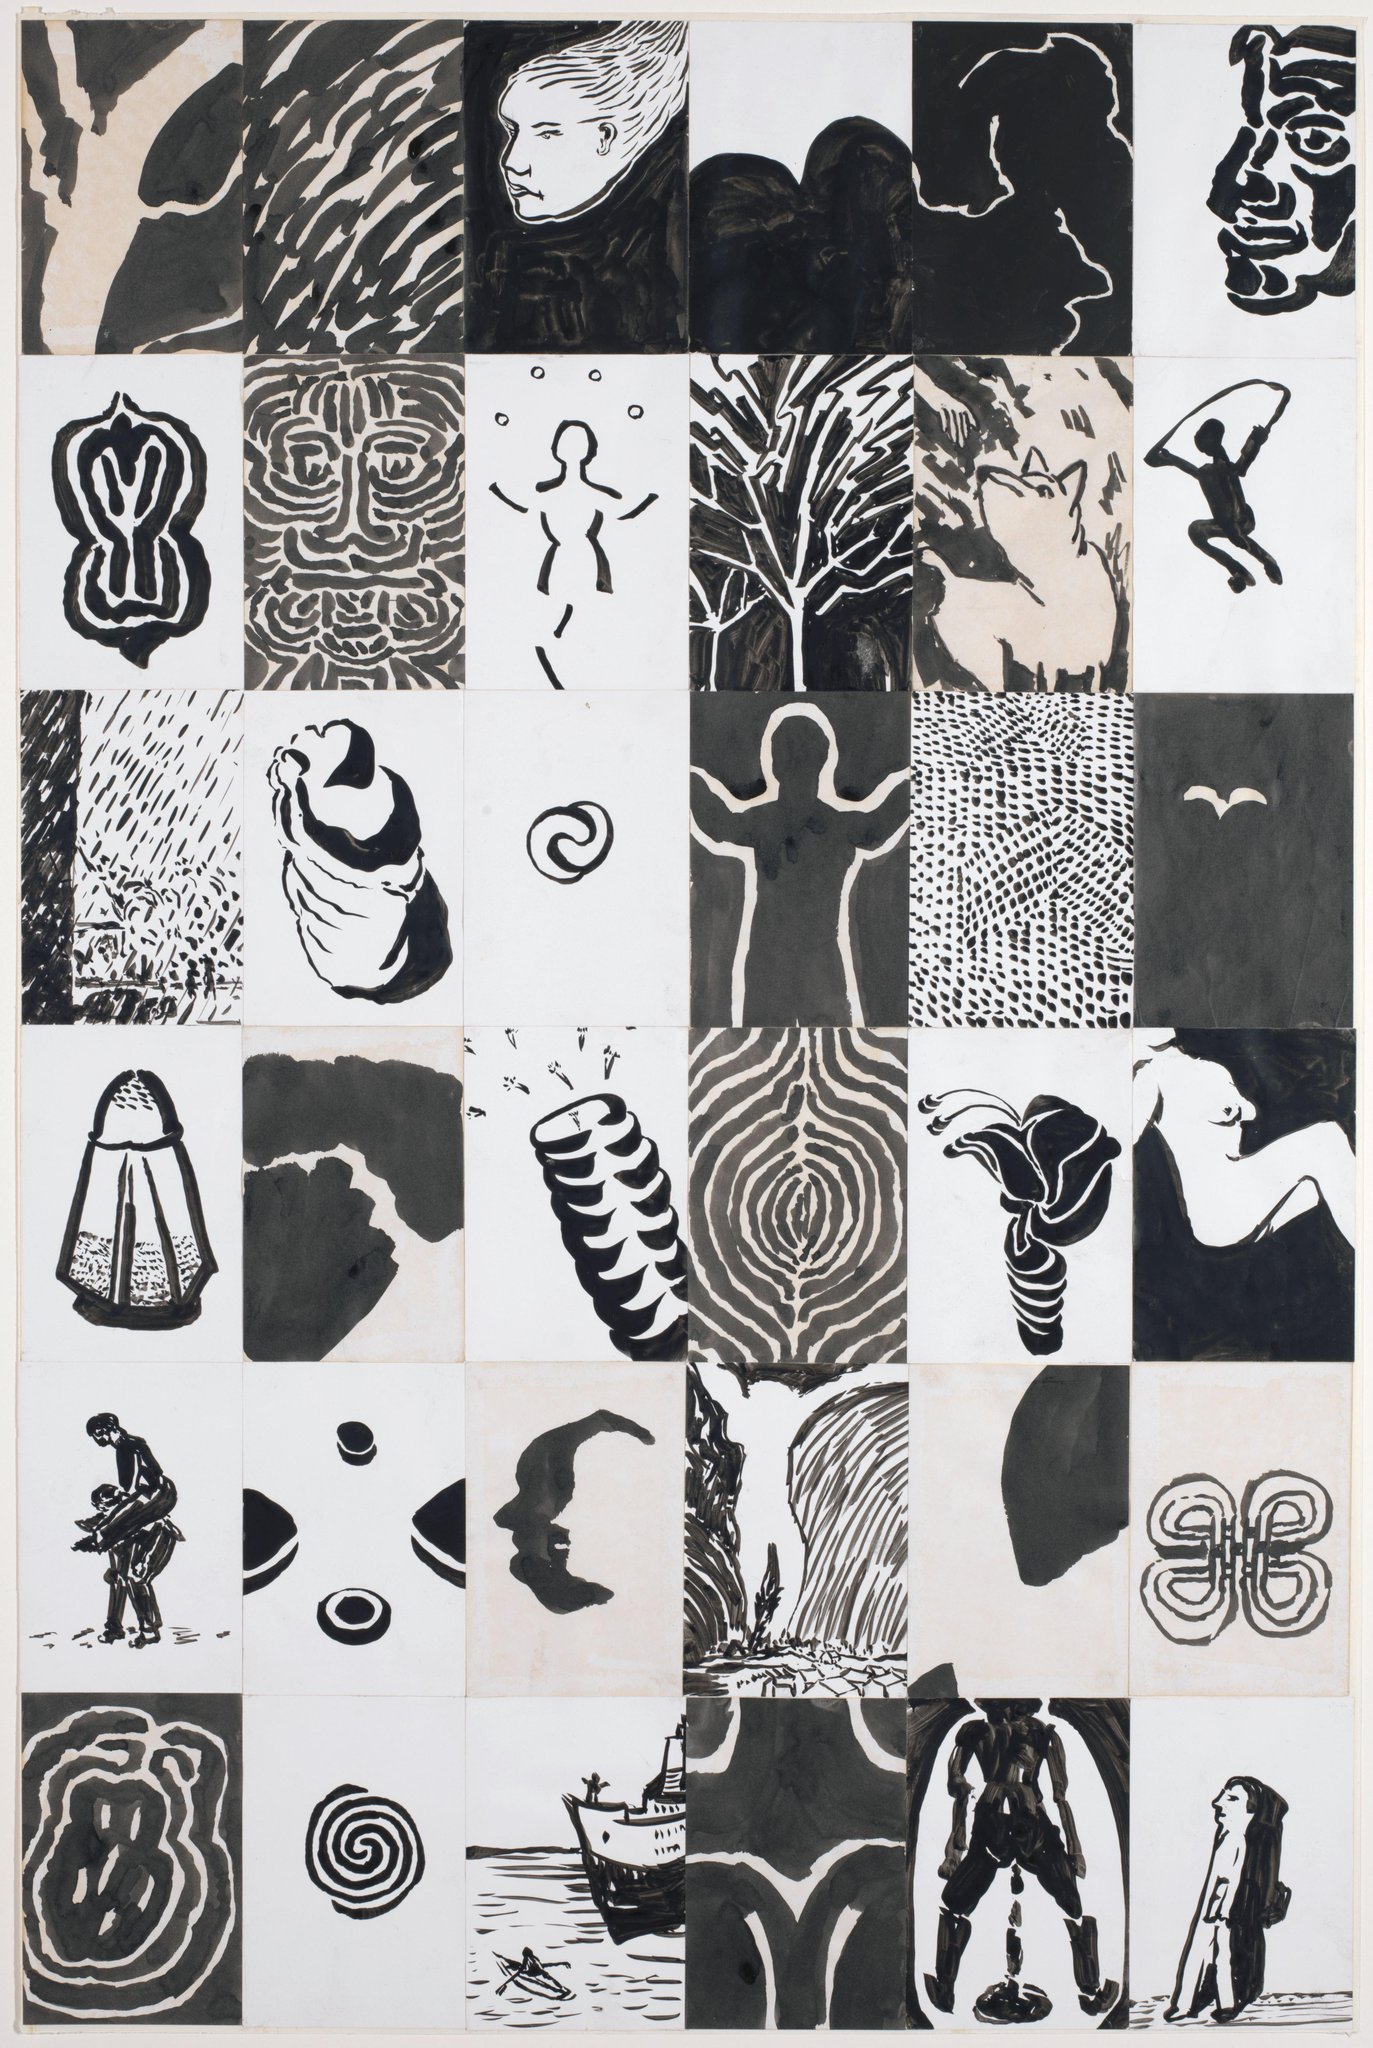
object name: drawing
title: 36 voorstellingen, waaronder zoutvaatje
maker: pieter holstein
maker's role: draughtsman, painter, print maker, sculptor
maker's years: 1934-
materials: ink, paper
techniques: brush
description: 36 voorstellingen binnen vierkanten, waaronder zoutvaatje, spiraal en touwtjespringende man.